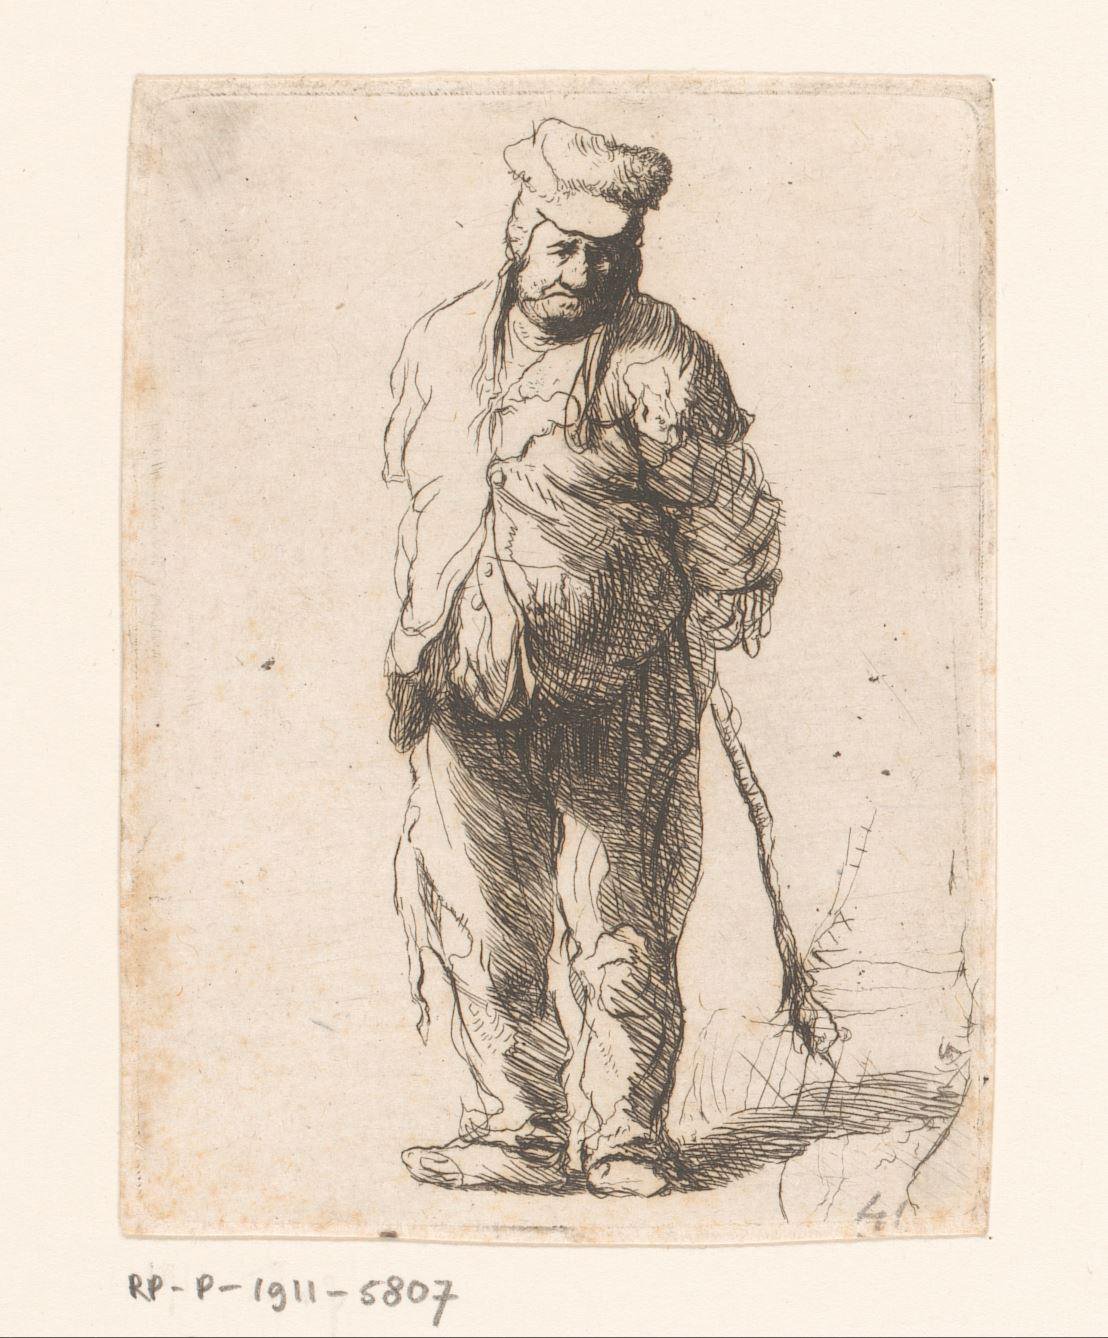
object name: print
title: Staande man met muts, mogelijk een bedelaar, van voren gezien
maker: sauveur legros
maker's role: print maker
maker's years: 1754-1834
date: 1764-1834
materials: paper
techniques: etching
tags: beggar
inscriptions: collector's mark: Lugt 2228